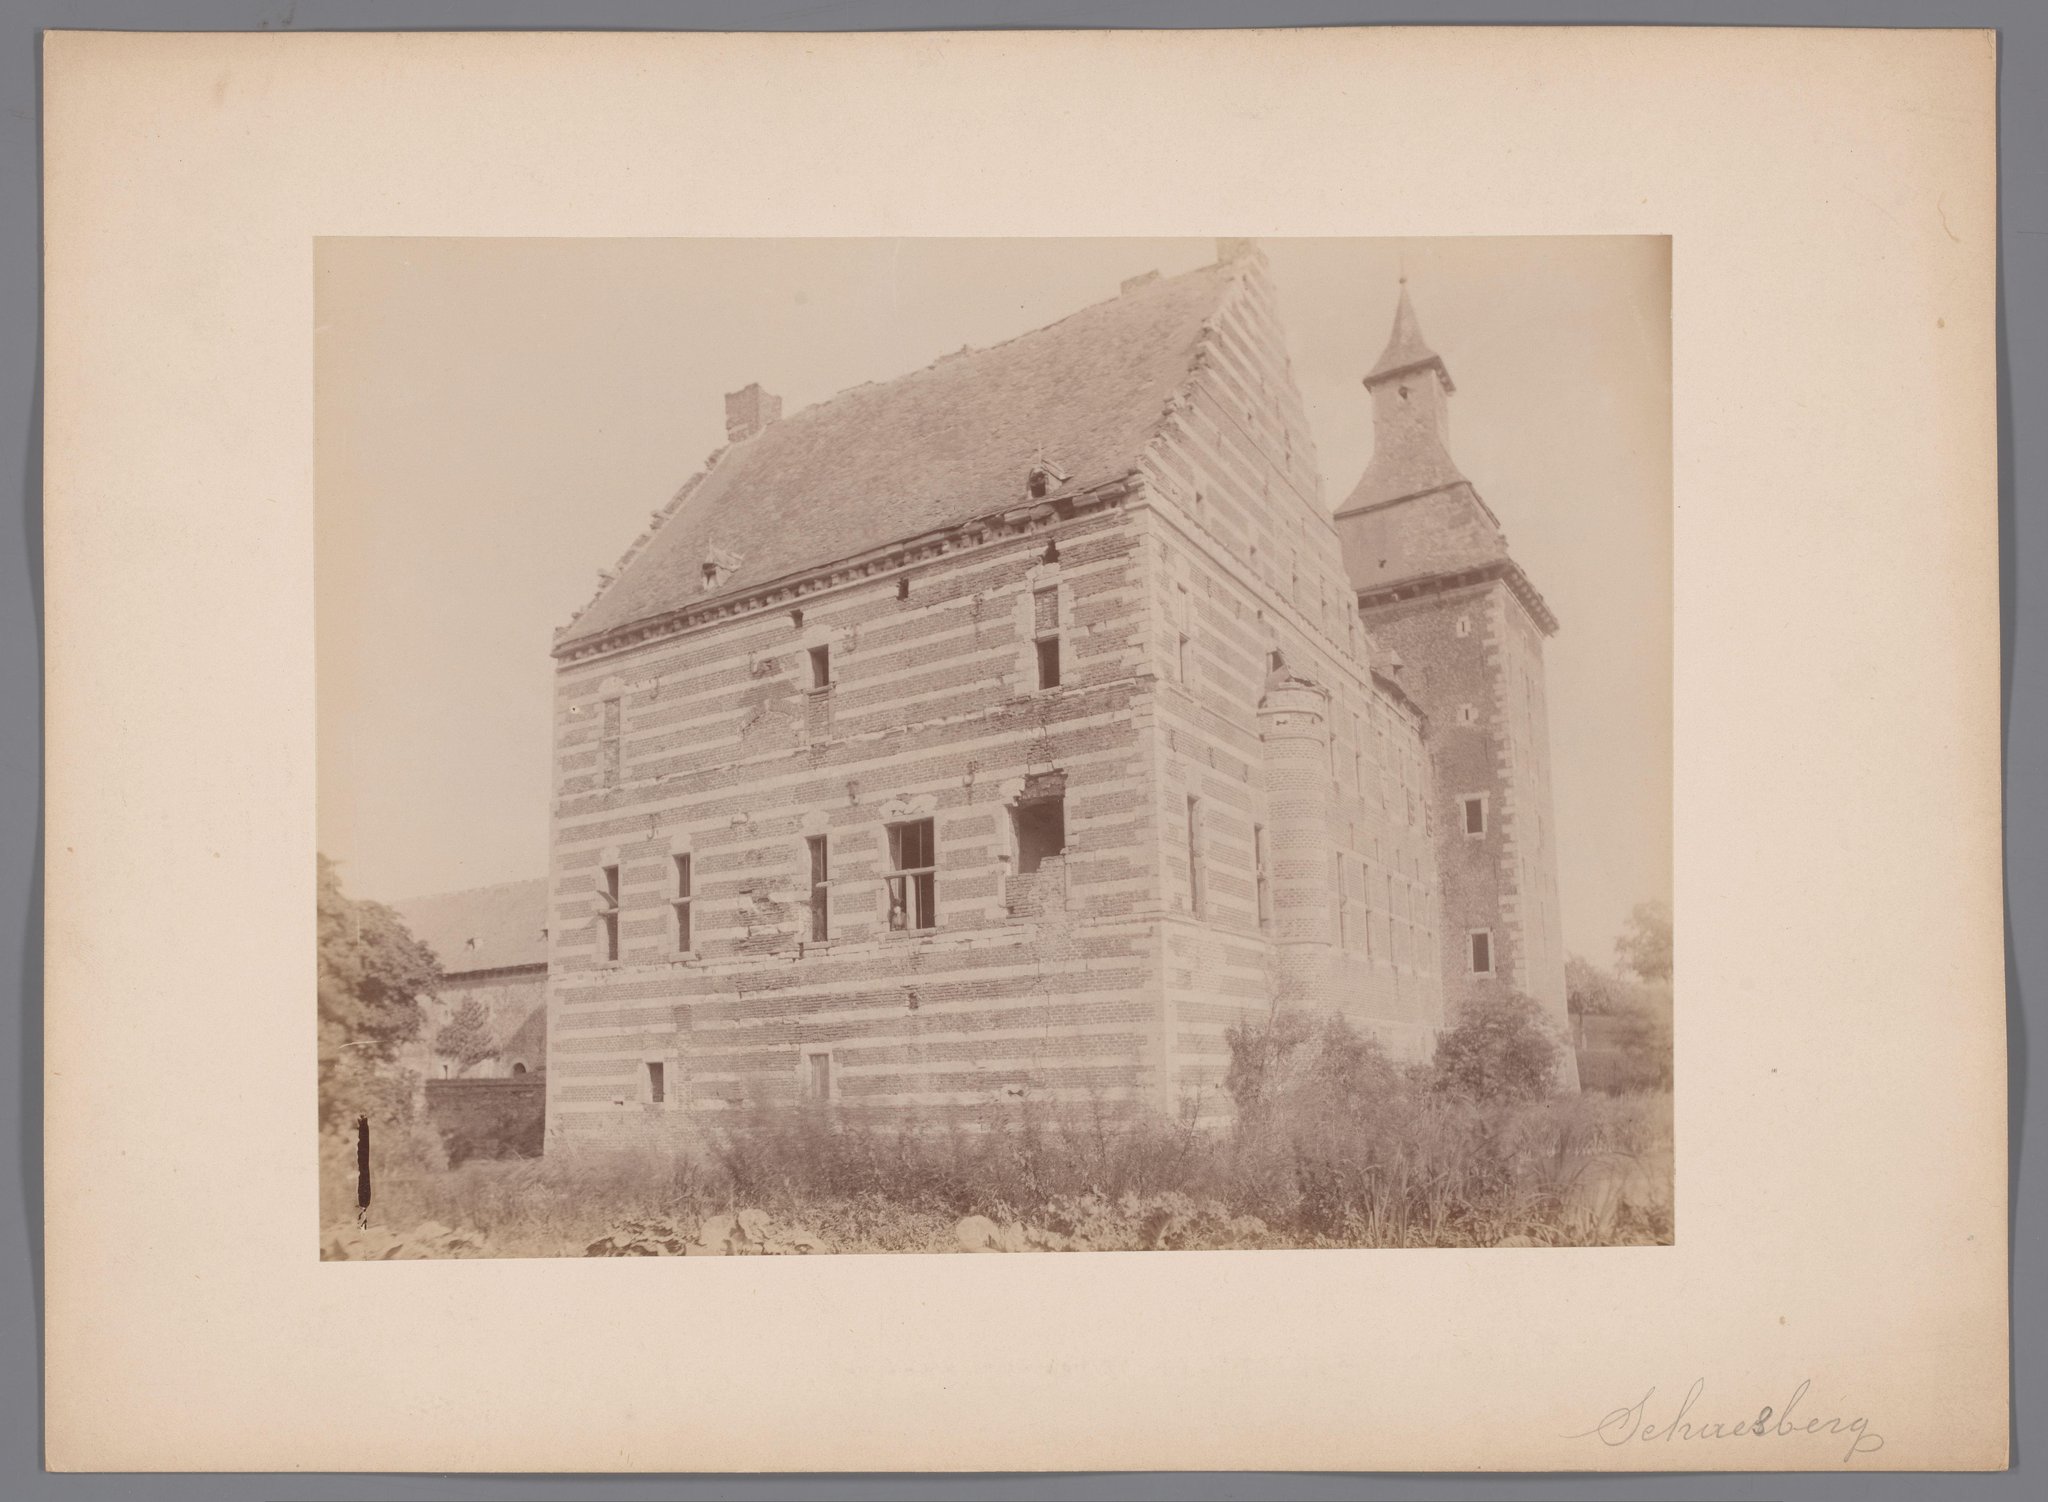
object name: photograph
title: Gezicht op Kasteel Schaesberg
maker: anoniem (monumentenzorg)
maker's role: fotograaf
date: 1890-1920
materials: cardboard, photographic support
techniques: albumen print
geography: schaesberg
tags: castle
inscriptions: annotation: ‘Schaesberg kasteel’, annotation: ‘Schaesberg’